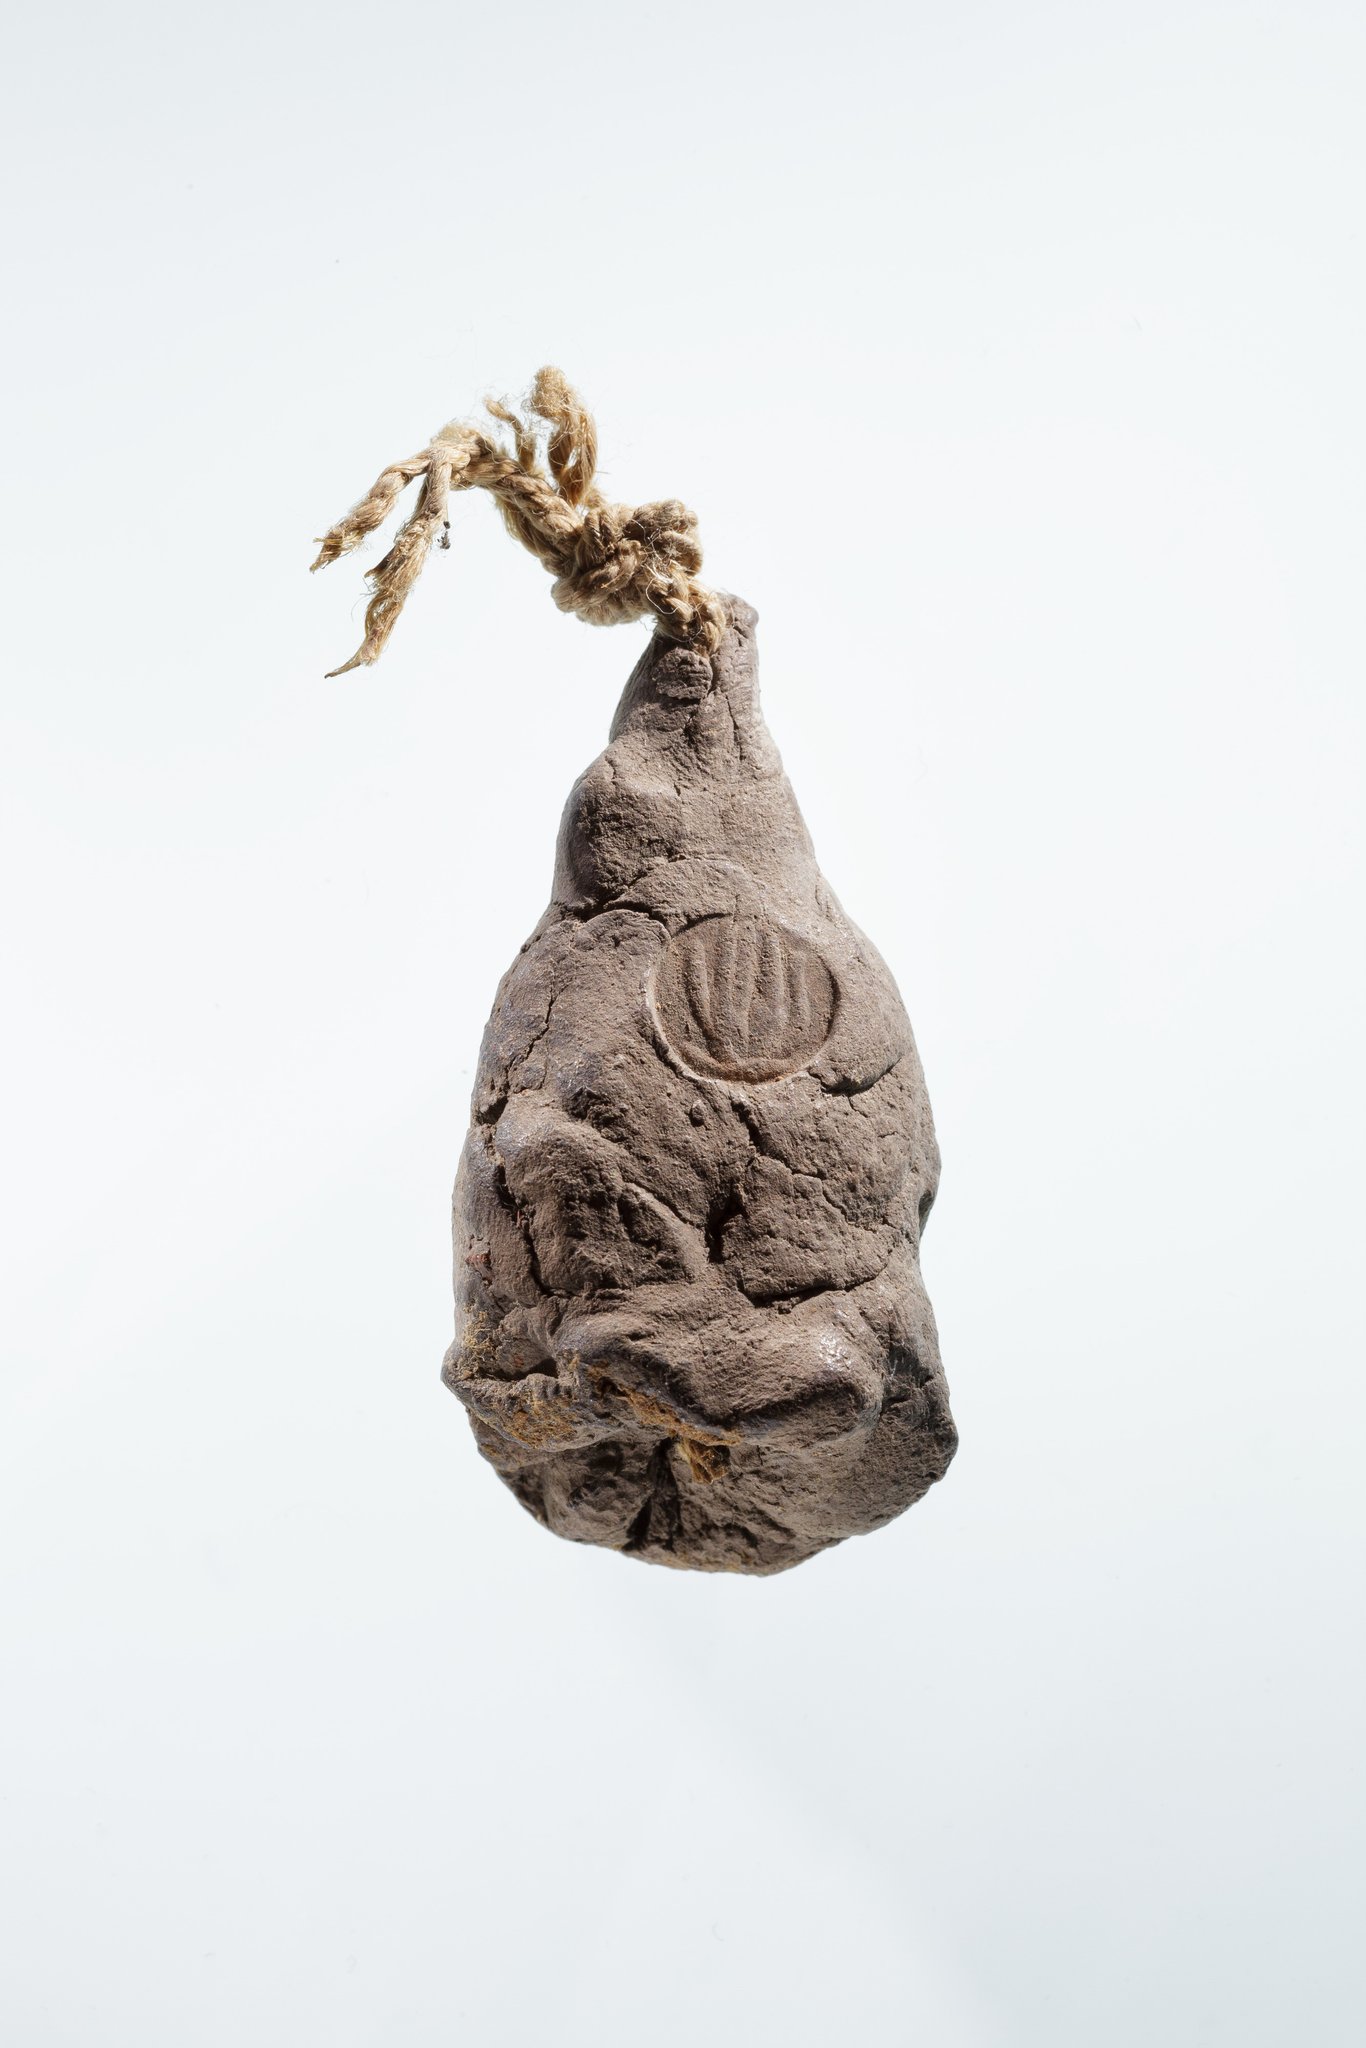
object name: sealing, from net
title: Sealing from net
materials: cord, mud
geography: egypt